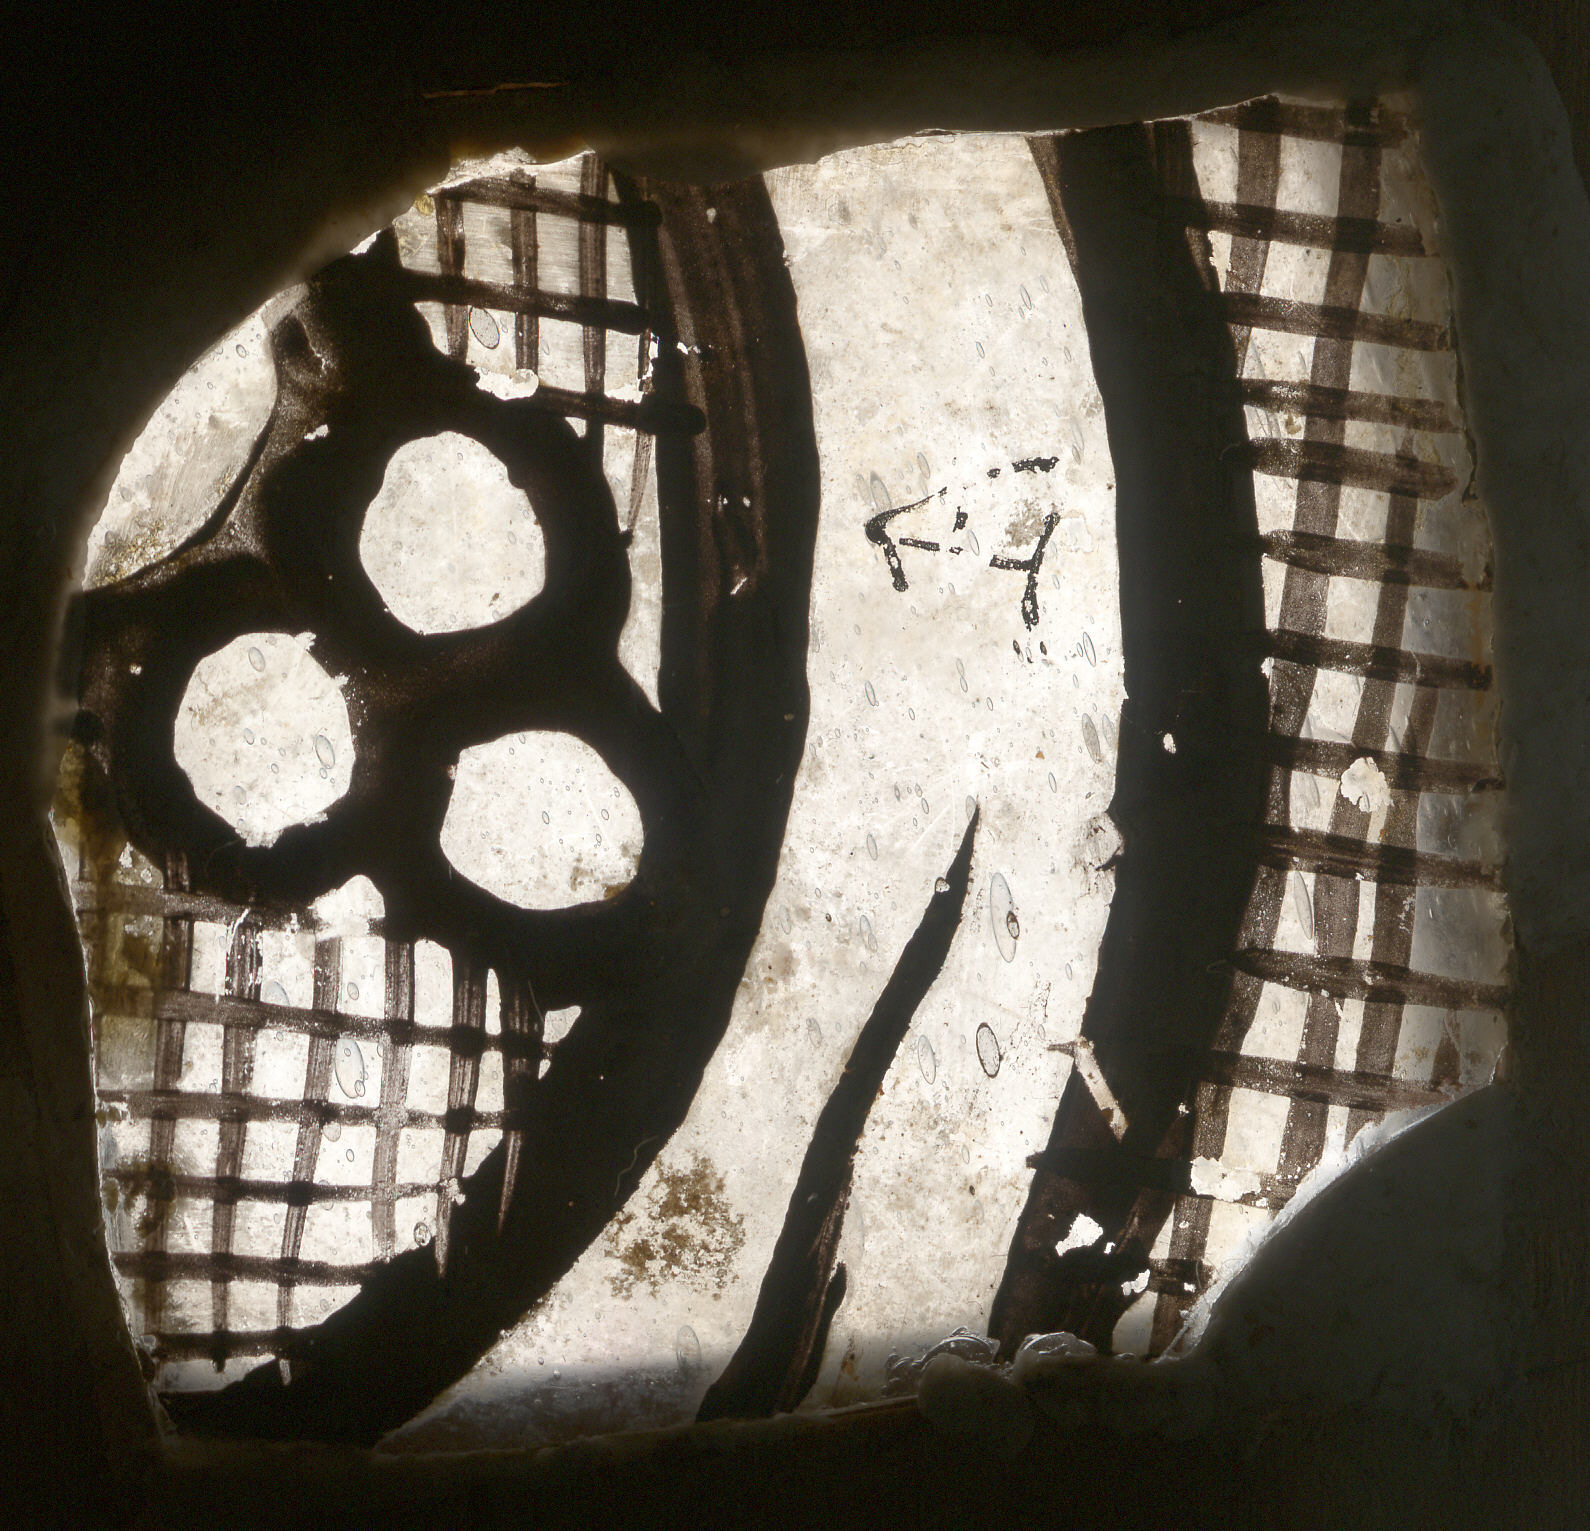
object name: fragment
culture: crusader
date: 1201-1300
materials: glass